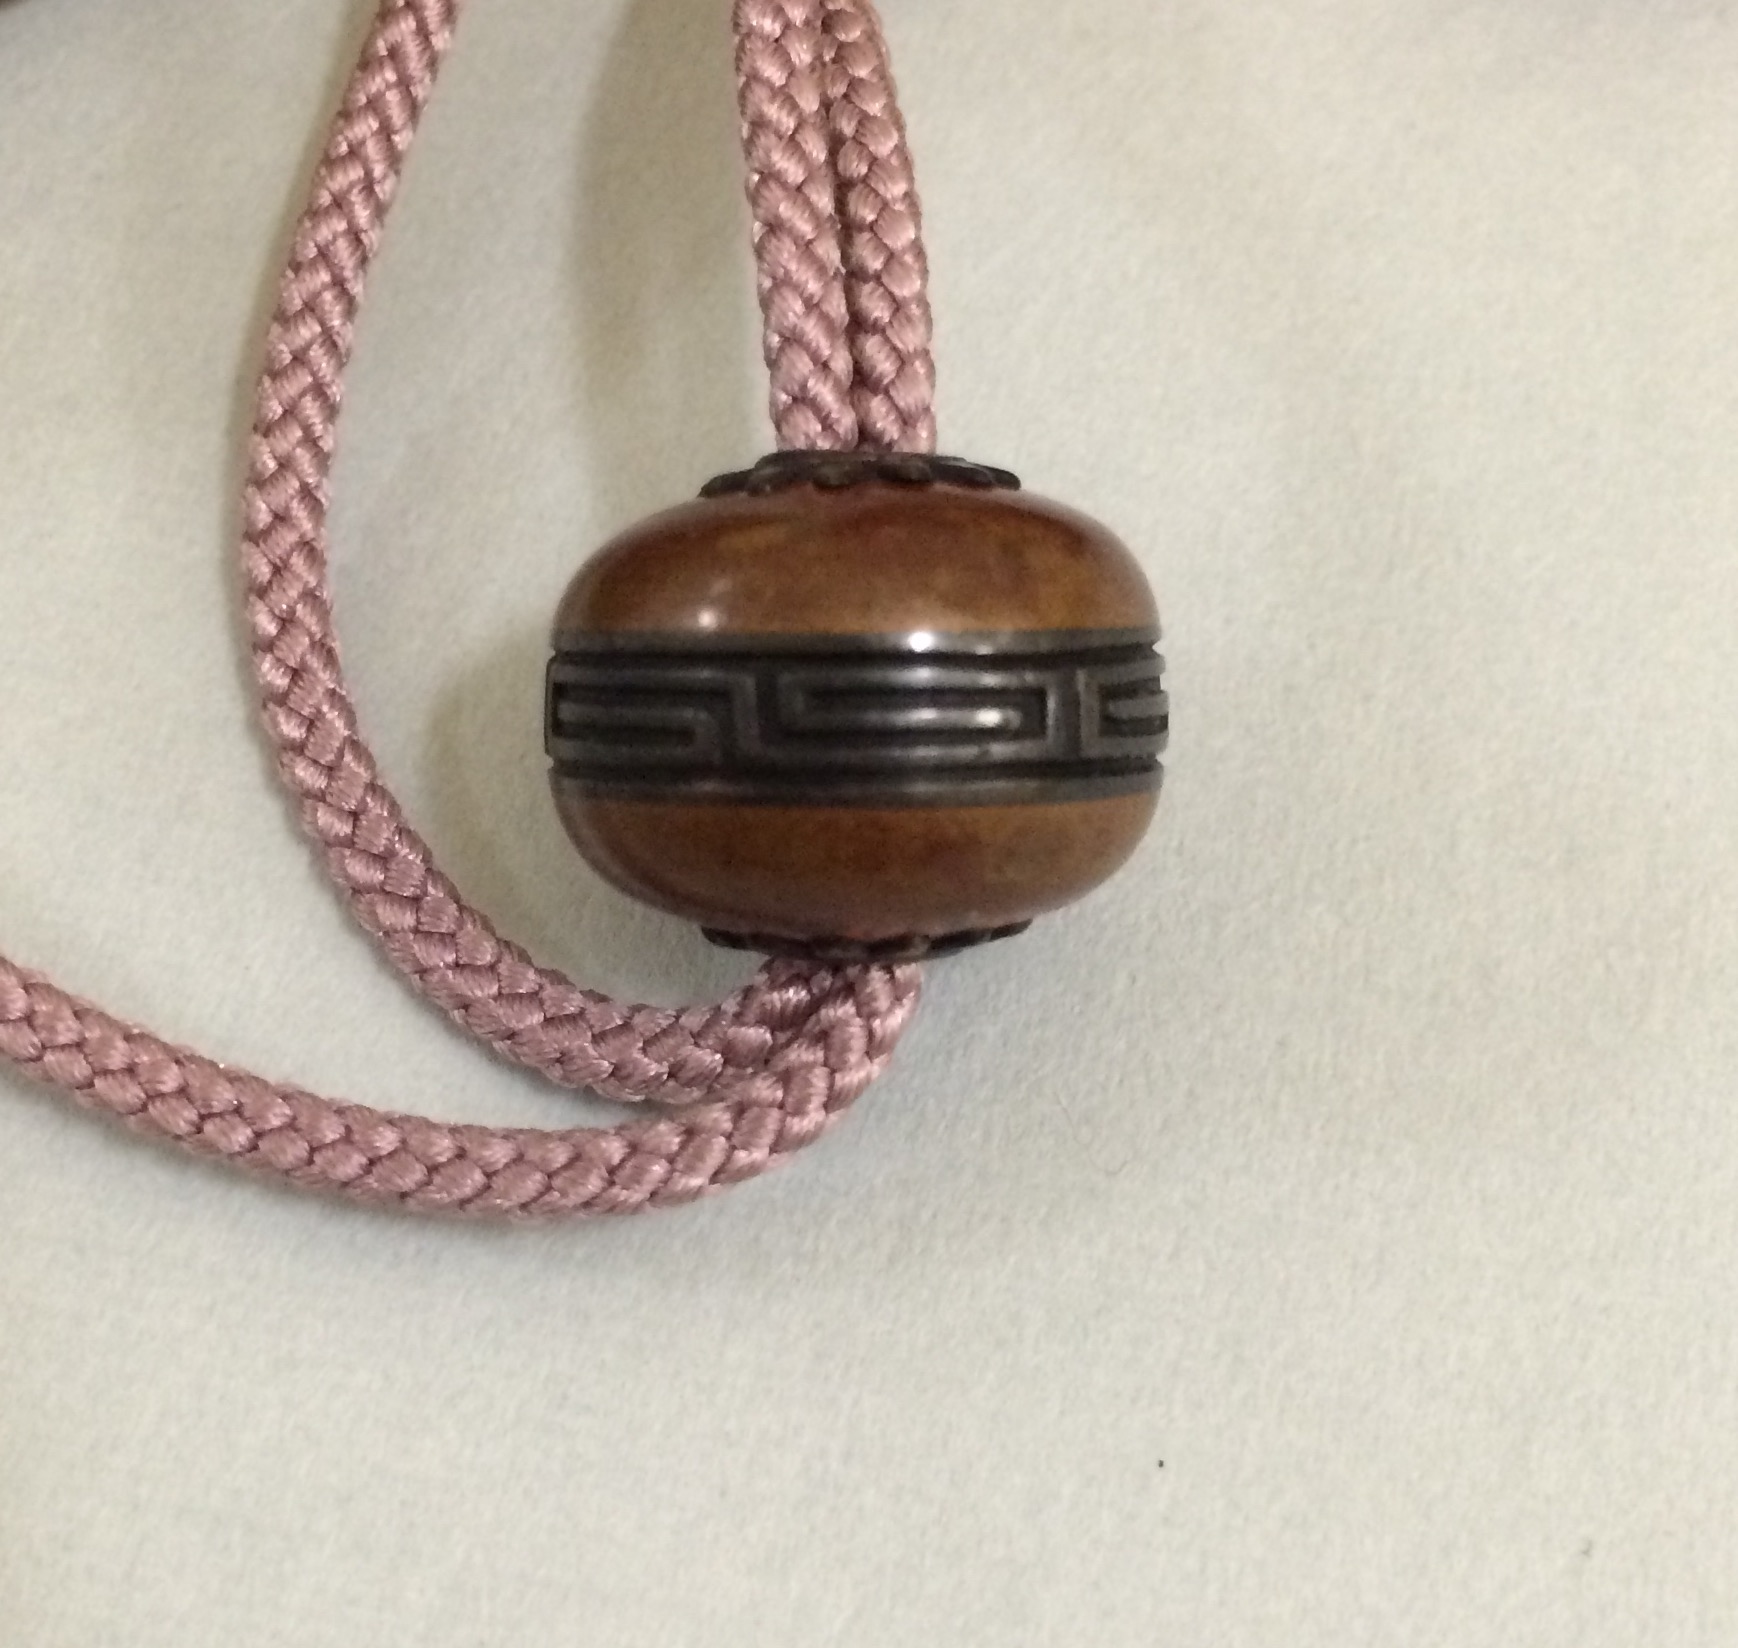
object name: ojime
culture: japanese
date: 1801-1900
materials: metal